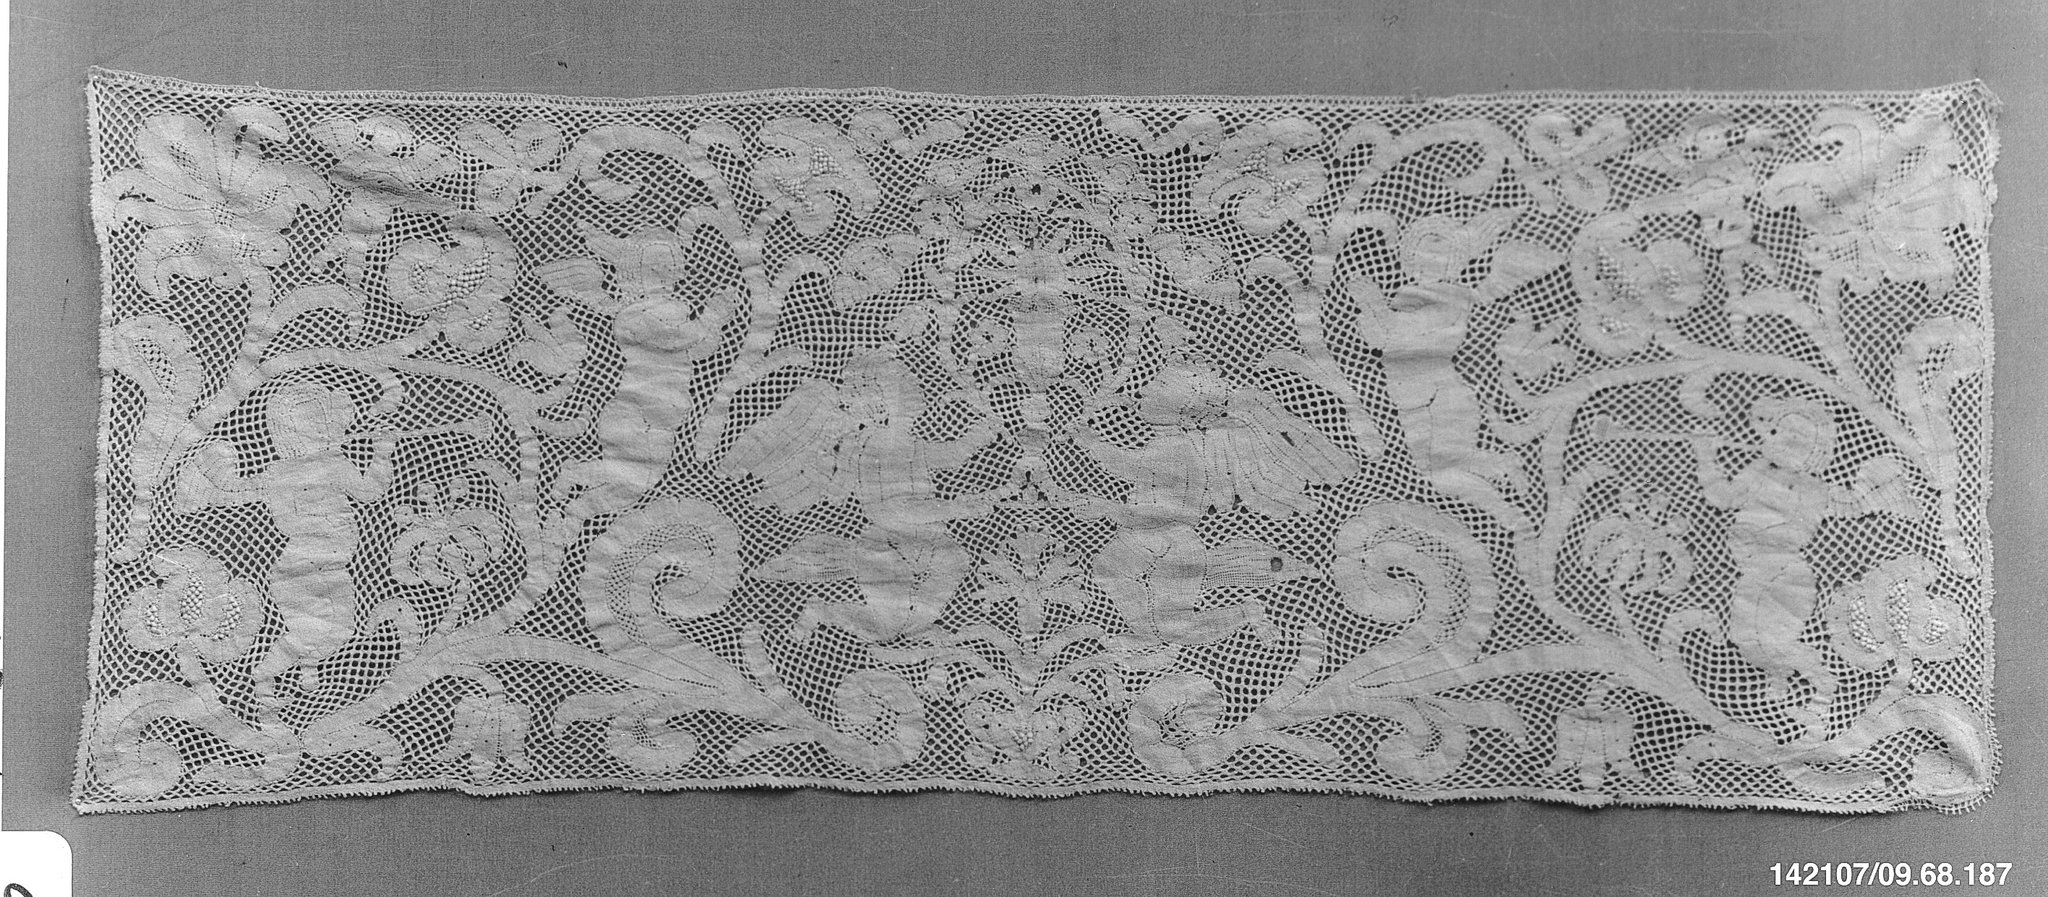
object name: panel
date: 1601-1700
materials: lace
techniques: lace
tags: angels